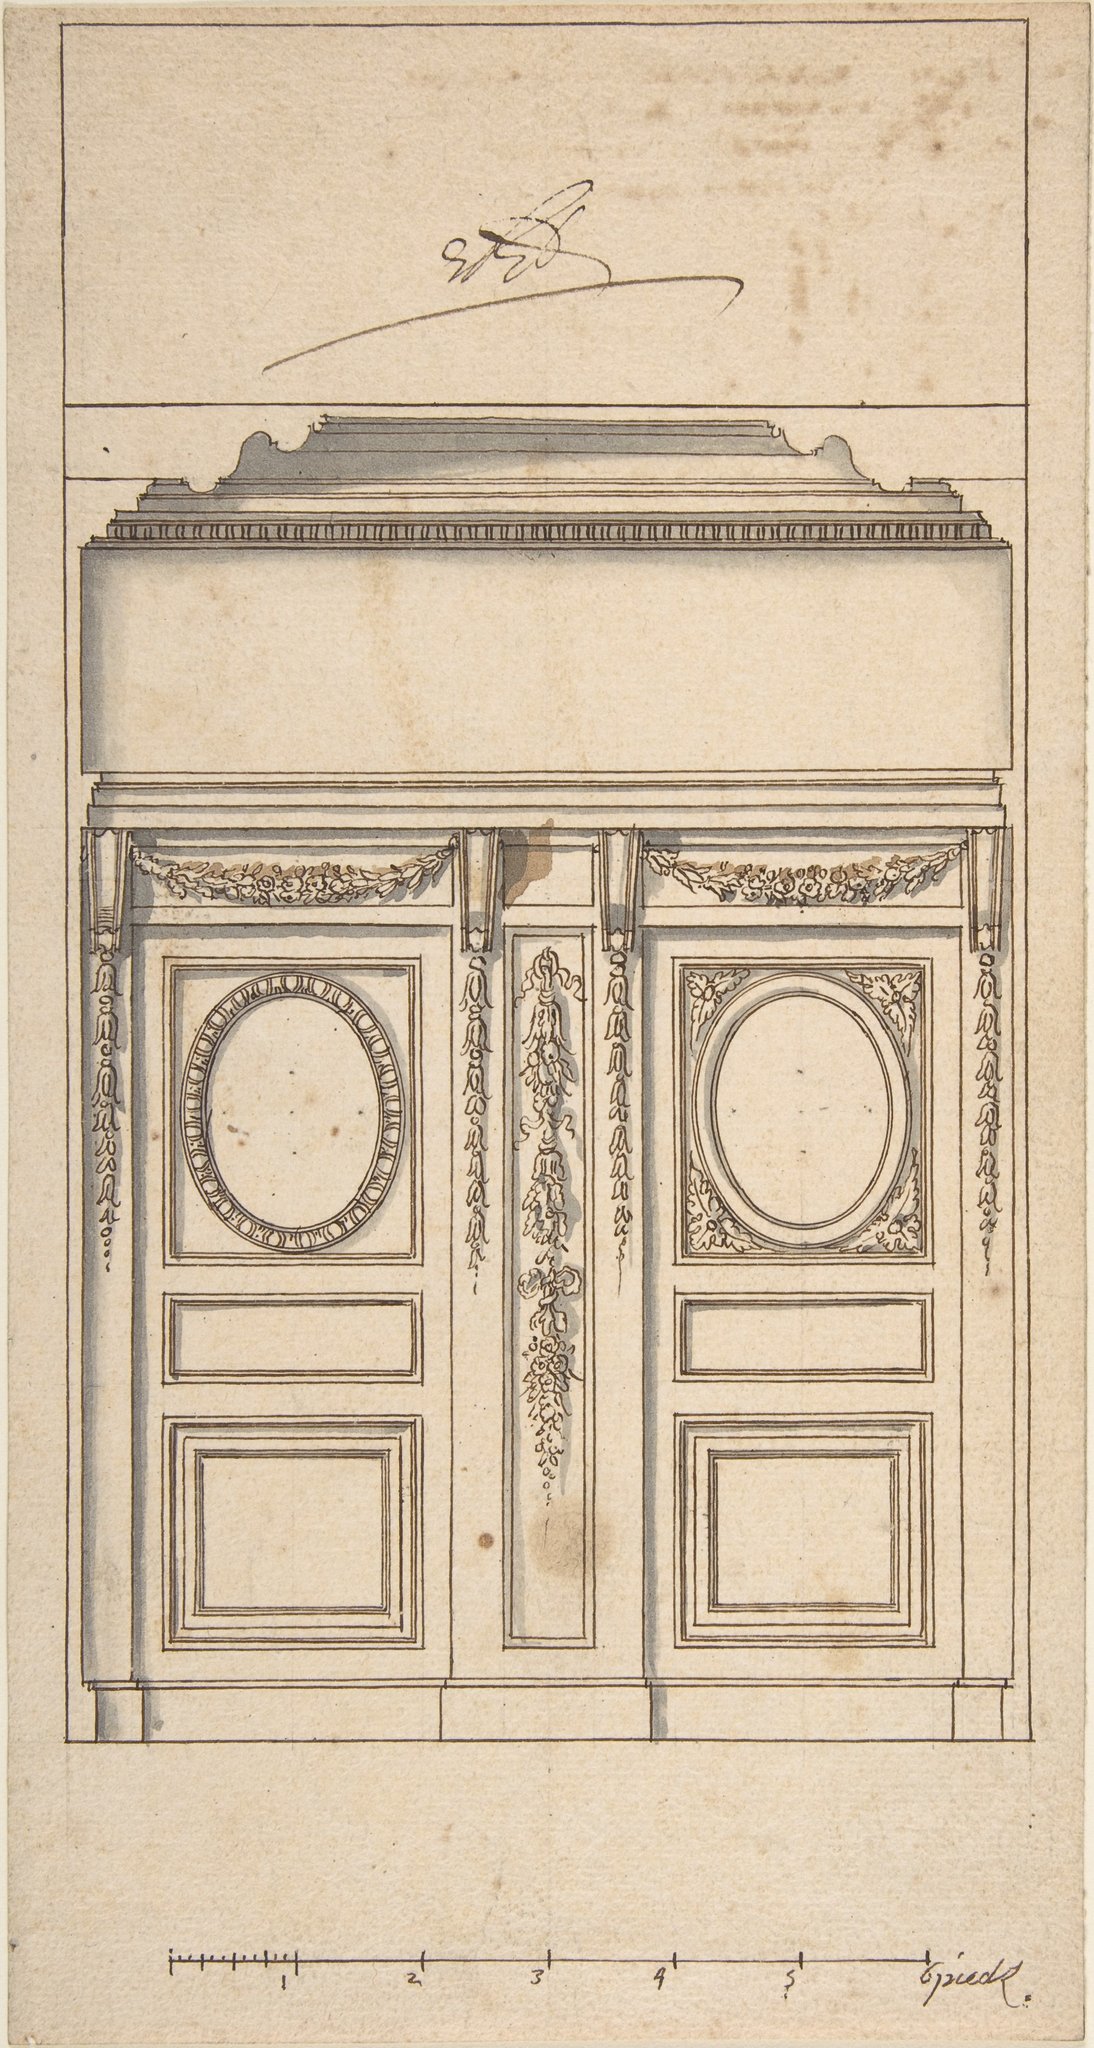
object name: drawing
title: Architectural Drawing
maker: anonymous, french, 18th century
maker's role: artist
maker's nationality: french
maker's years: 1700-1800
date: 1701-1800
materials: ink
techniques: brush, pen, wash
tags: architecture,garlands